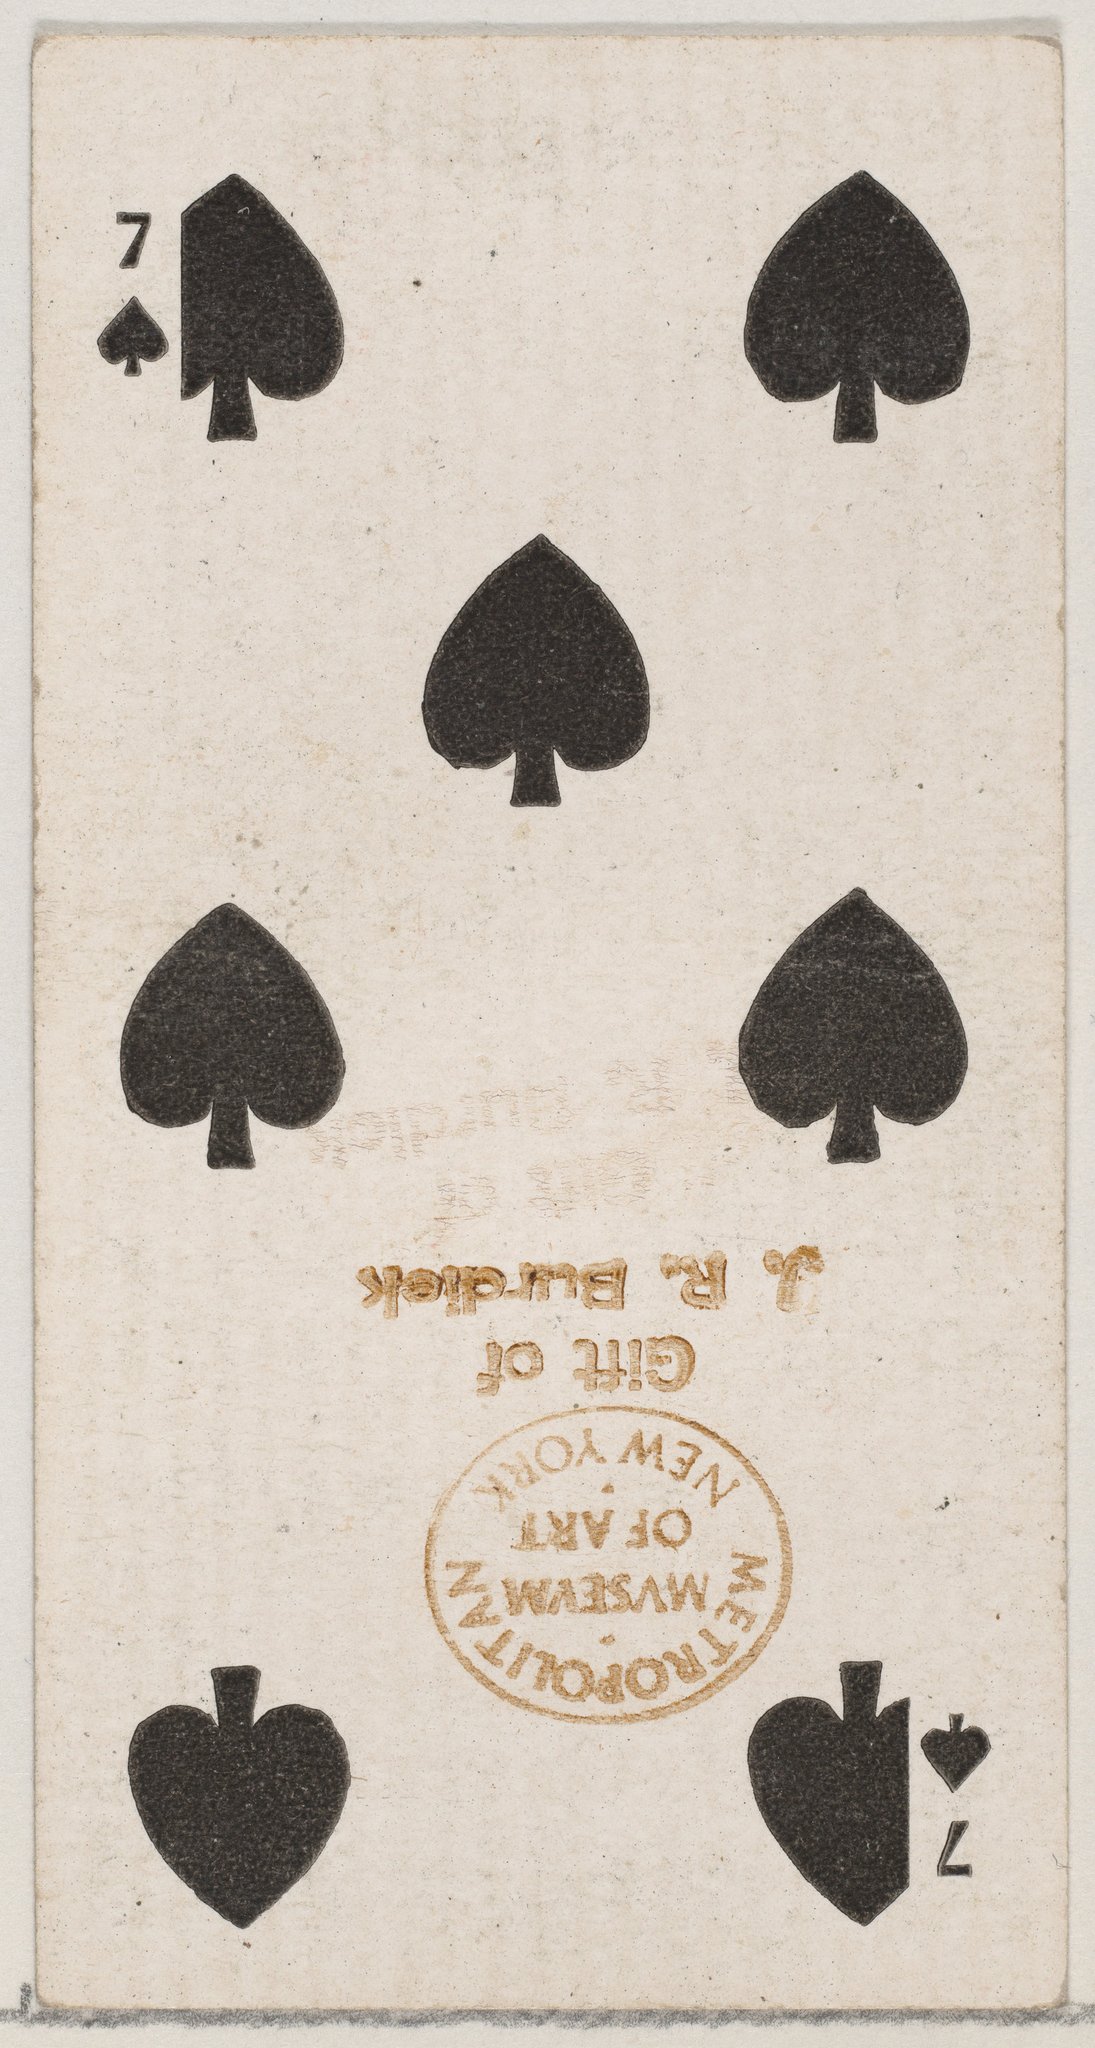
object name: print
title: Seven Spades (black), from the Playing Cards series (N84) for Duke brand cigarettes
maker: w. duke, sons & co.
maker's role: publisher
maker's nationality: american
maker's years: 1870-1920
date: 1888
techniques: color lithograph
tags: playing cards